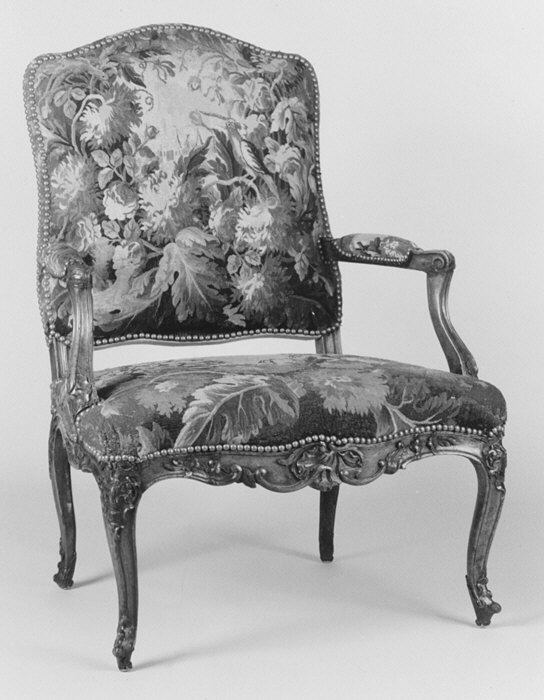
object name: armchair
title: Armchair (one of a set of four)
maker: aubusson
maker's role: factory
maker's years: 1665-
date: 1701-1800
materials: wood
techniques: carving, tapestry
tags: flowers